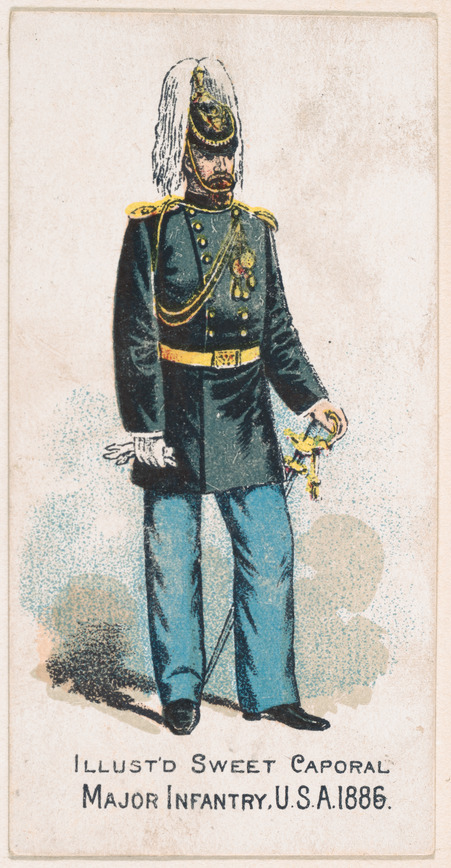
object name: print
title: Major Infantry, United States Army, 1886, from the Military Series (N224) issued by Kinney Tobacco Company to promote Sweet Caporal Cigarettes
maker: kinney brothers tobacco company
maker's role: publisher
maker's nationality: american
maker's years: 1869-2011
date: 1888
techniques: color lithograph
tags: military,men